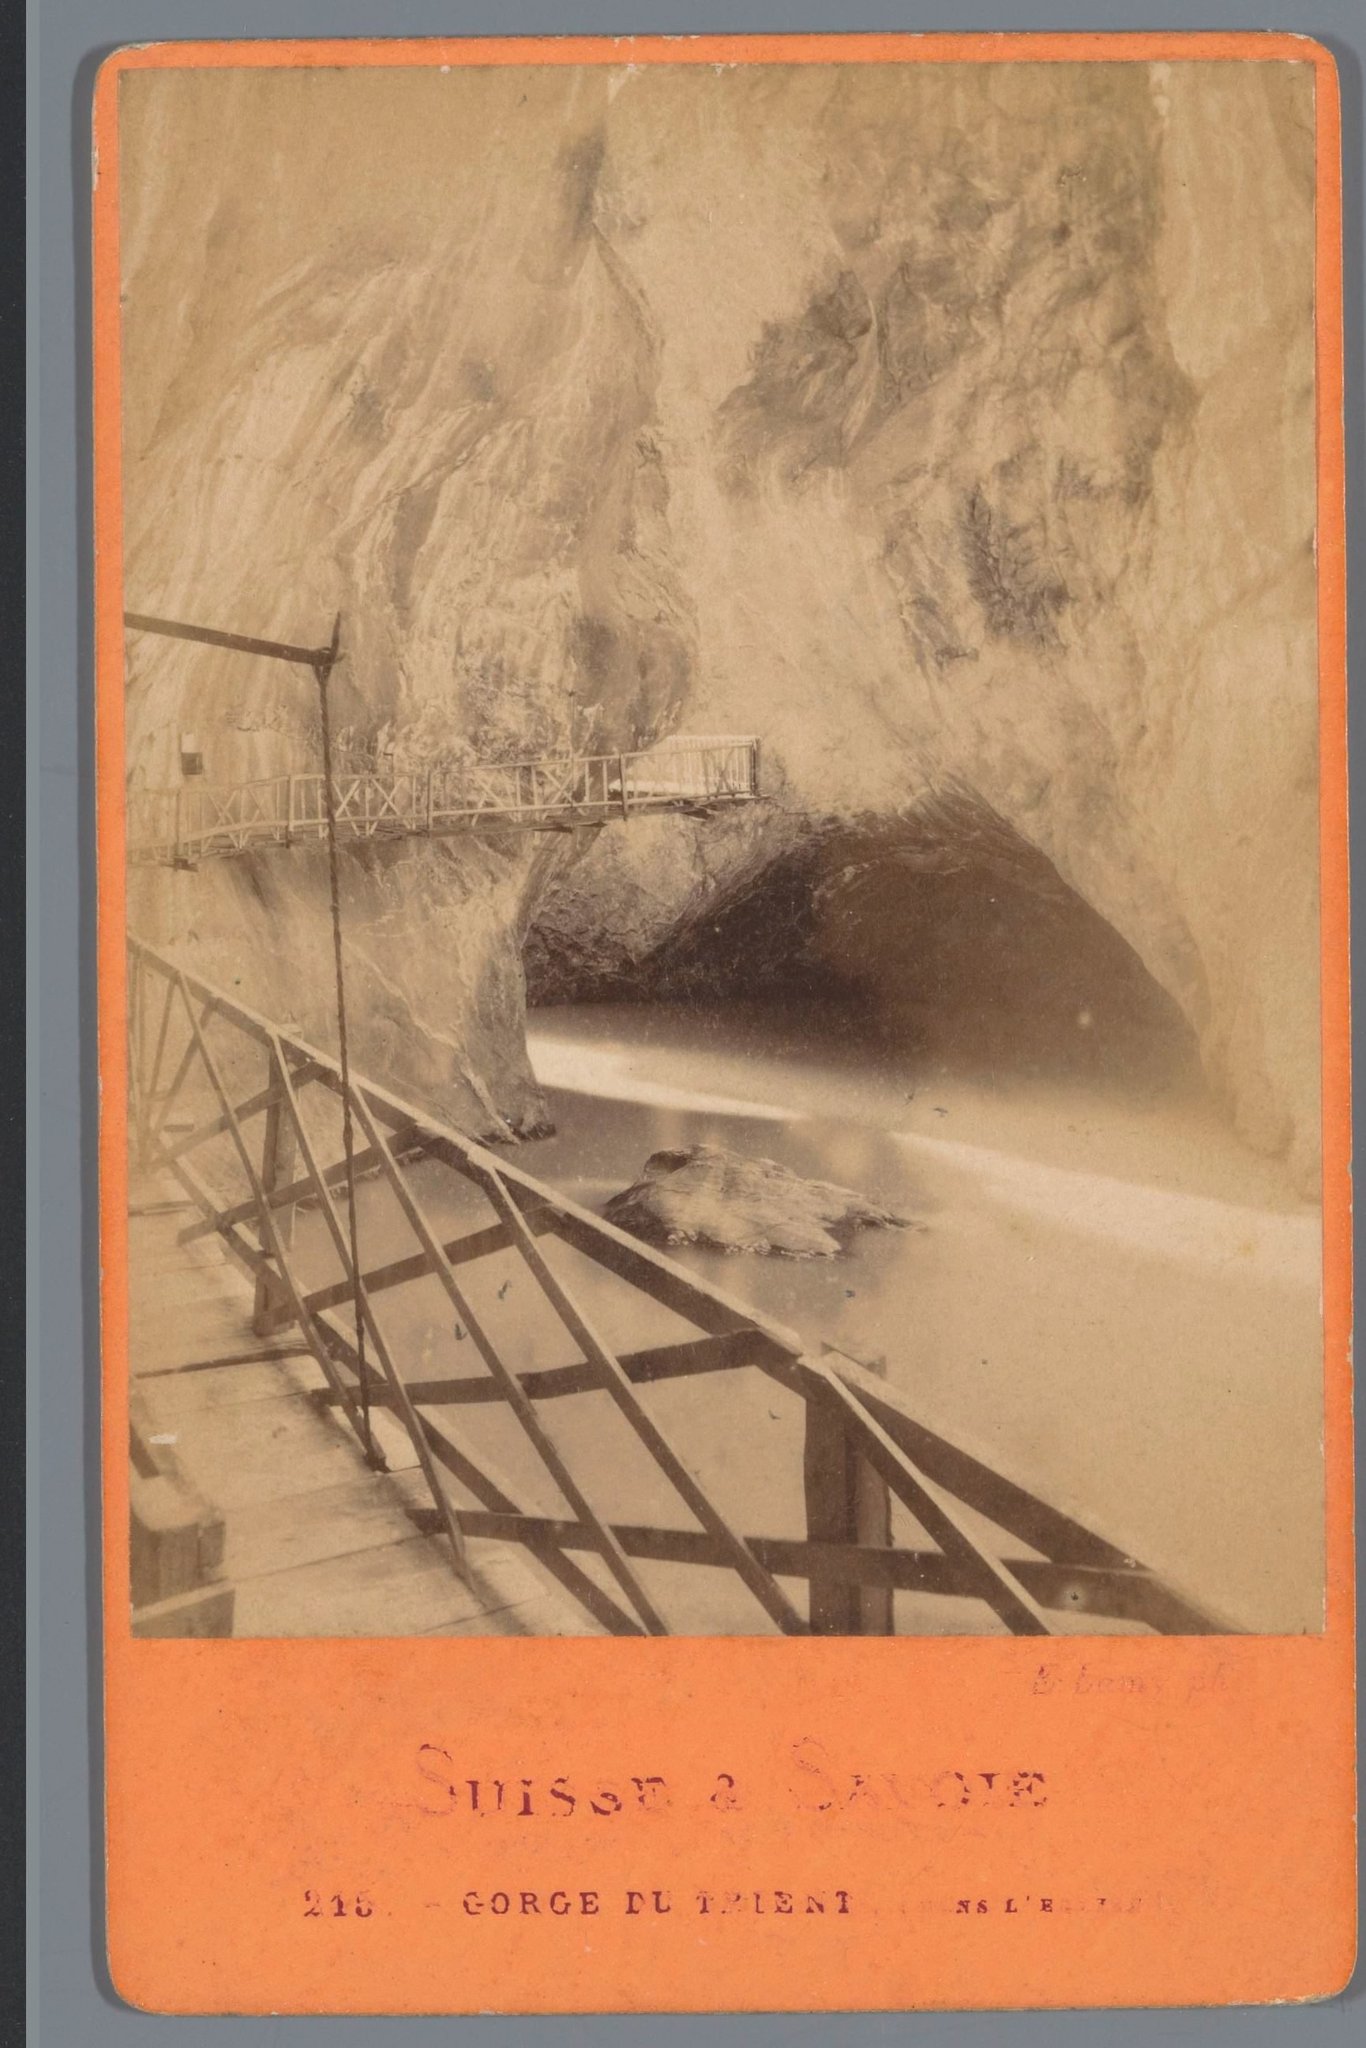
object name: photograph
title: Suisse & Savoie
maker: ernest eléonor pierre lamy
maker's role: publisher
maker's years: 1828-1900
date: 1868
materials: cardboard, paper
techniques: albumen print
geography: martigny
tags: ravine, chasm, abyss, canyon, bridge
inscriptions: number: ‘215’, inscription: ‘[...]/ Lamy 16 Août./ 1873.’